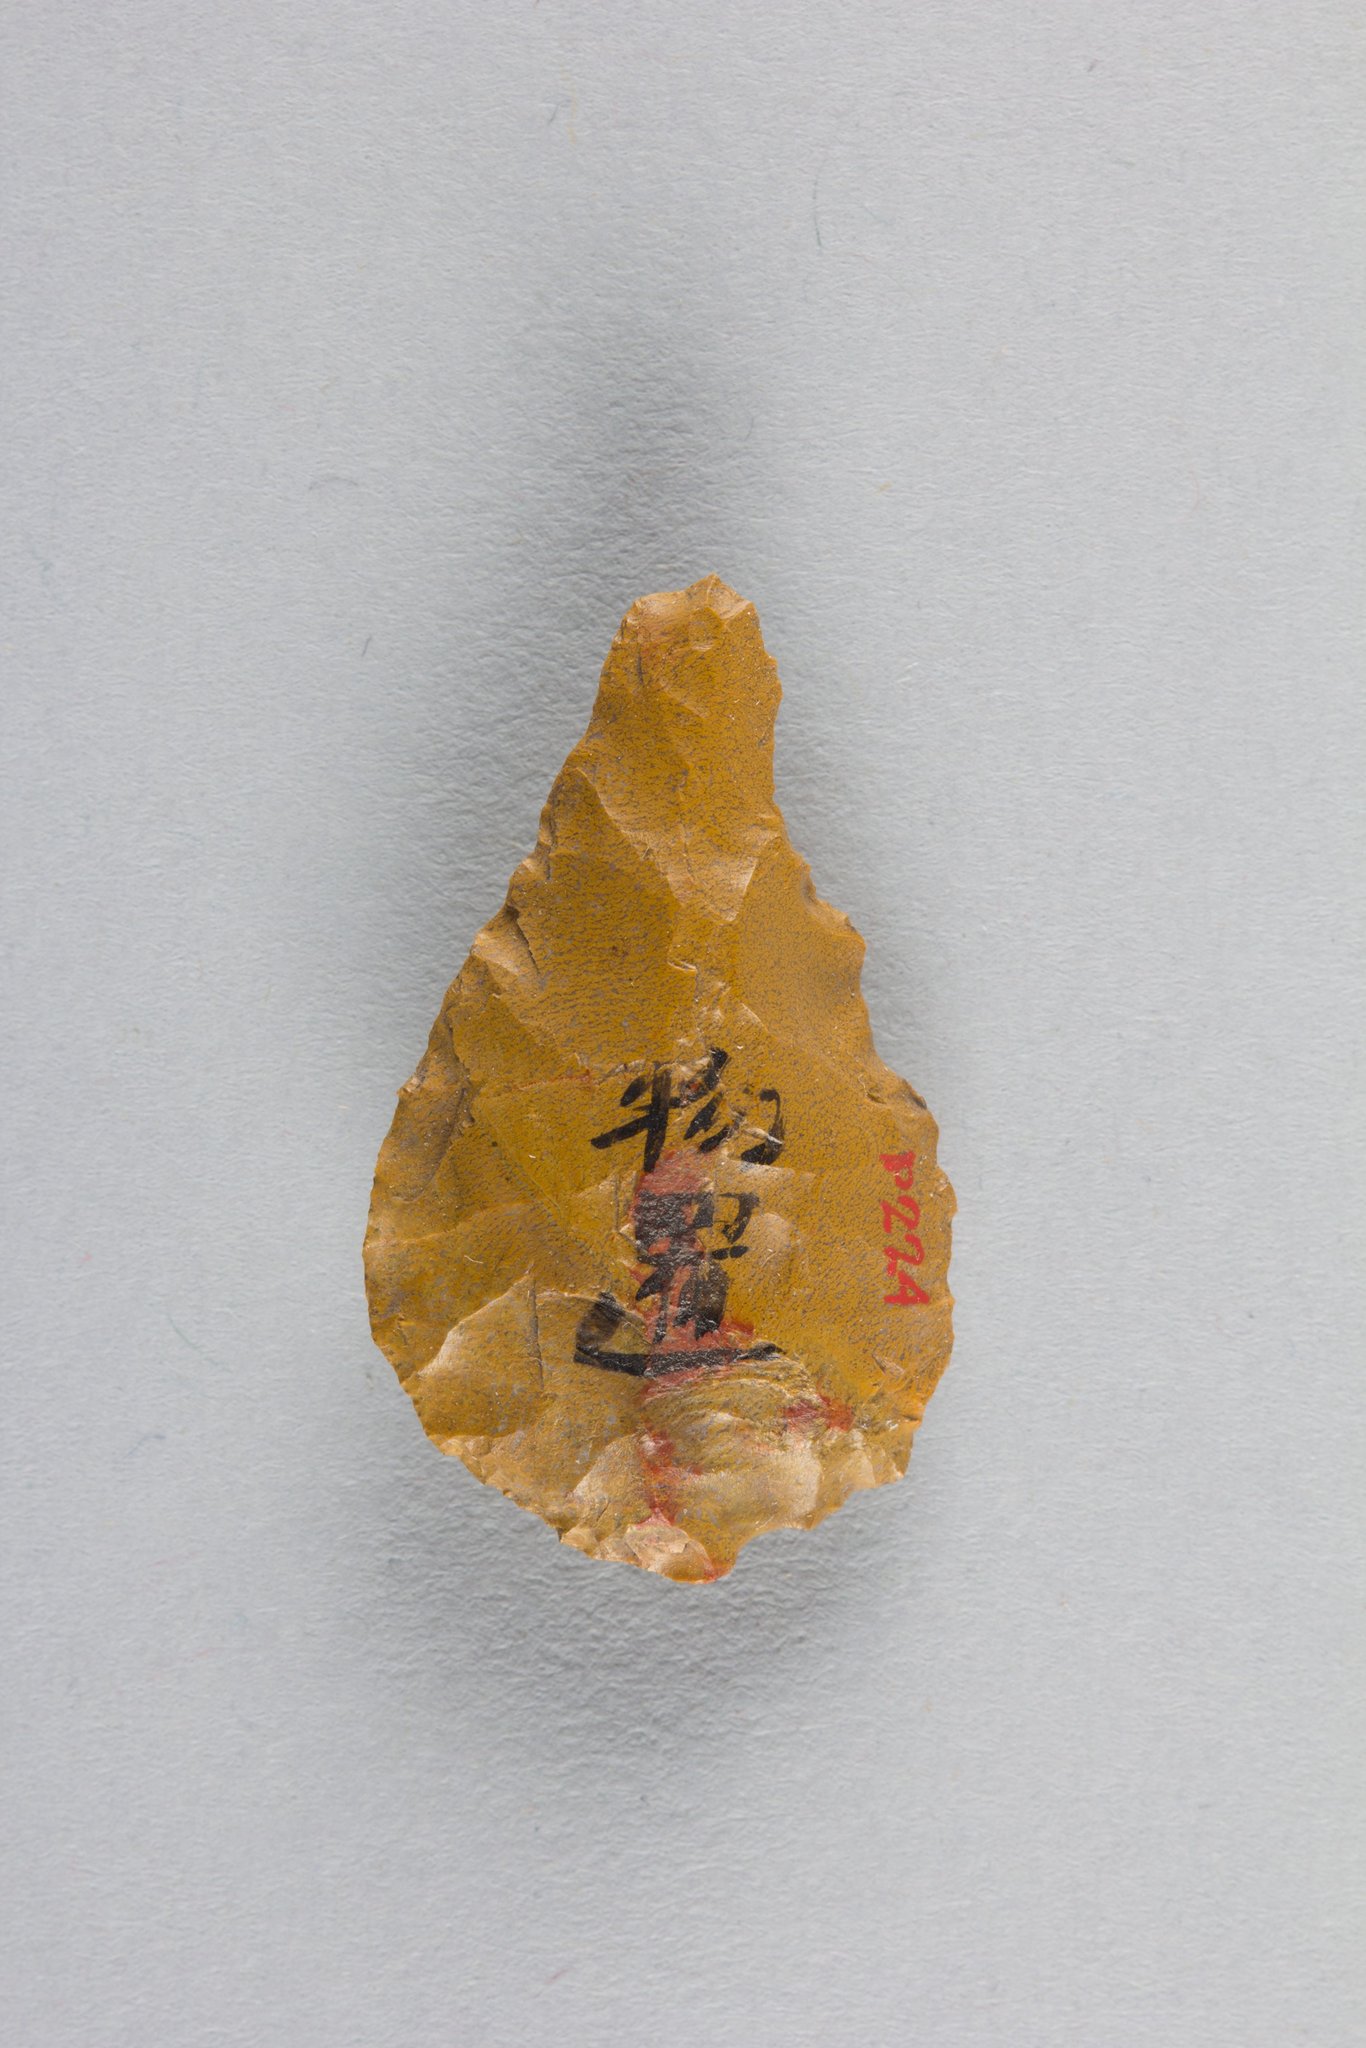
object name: arrowhead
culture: japanese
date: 1500-1000 BCE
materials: stone